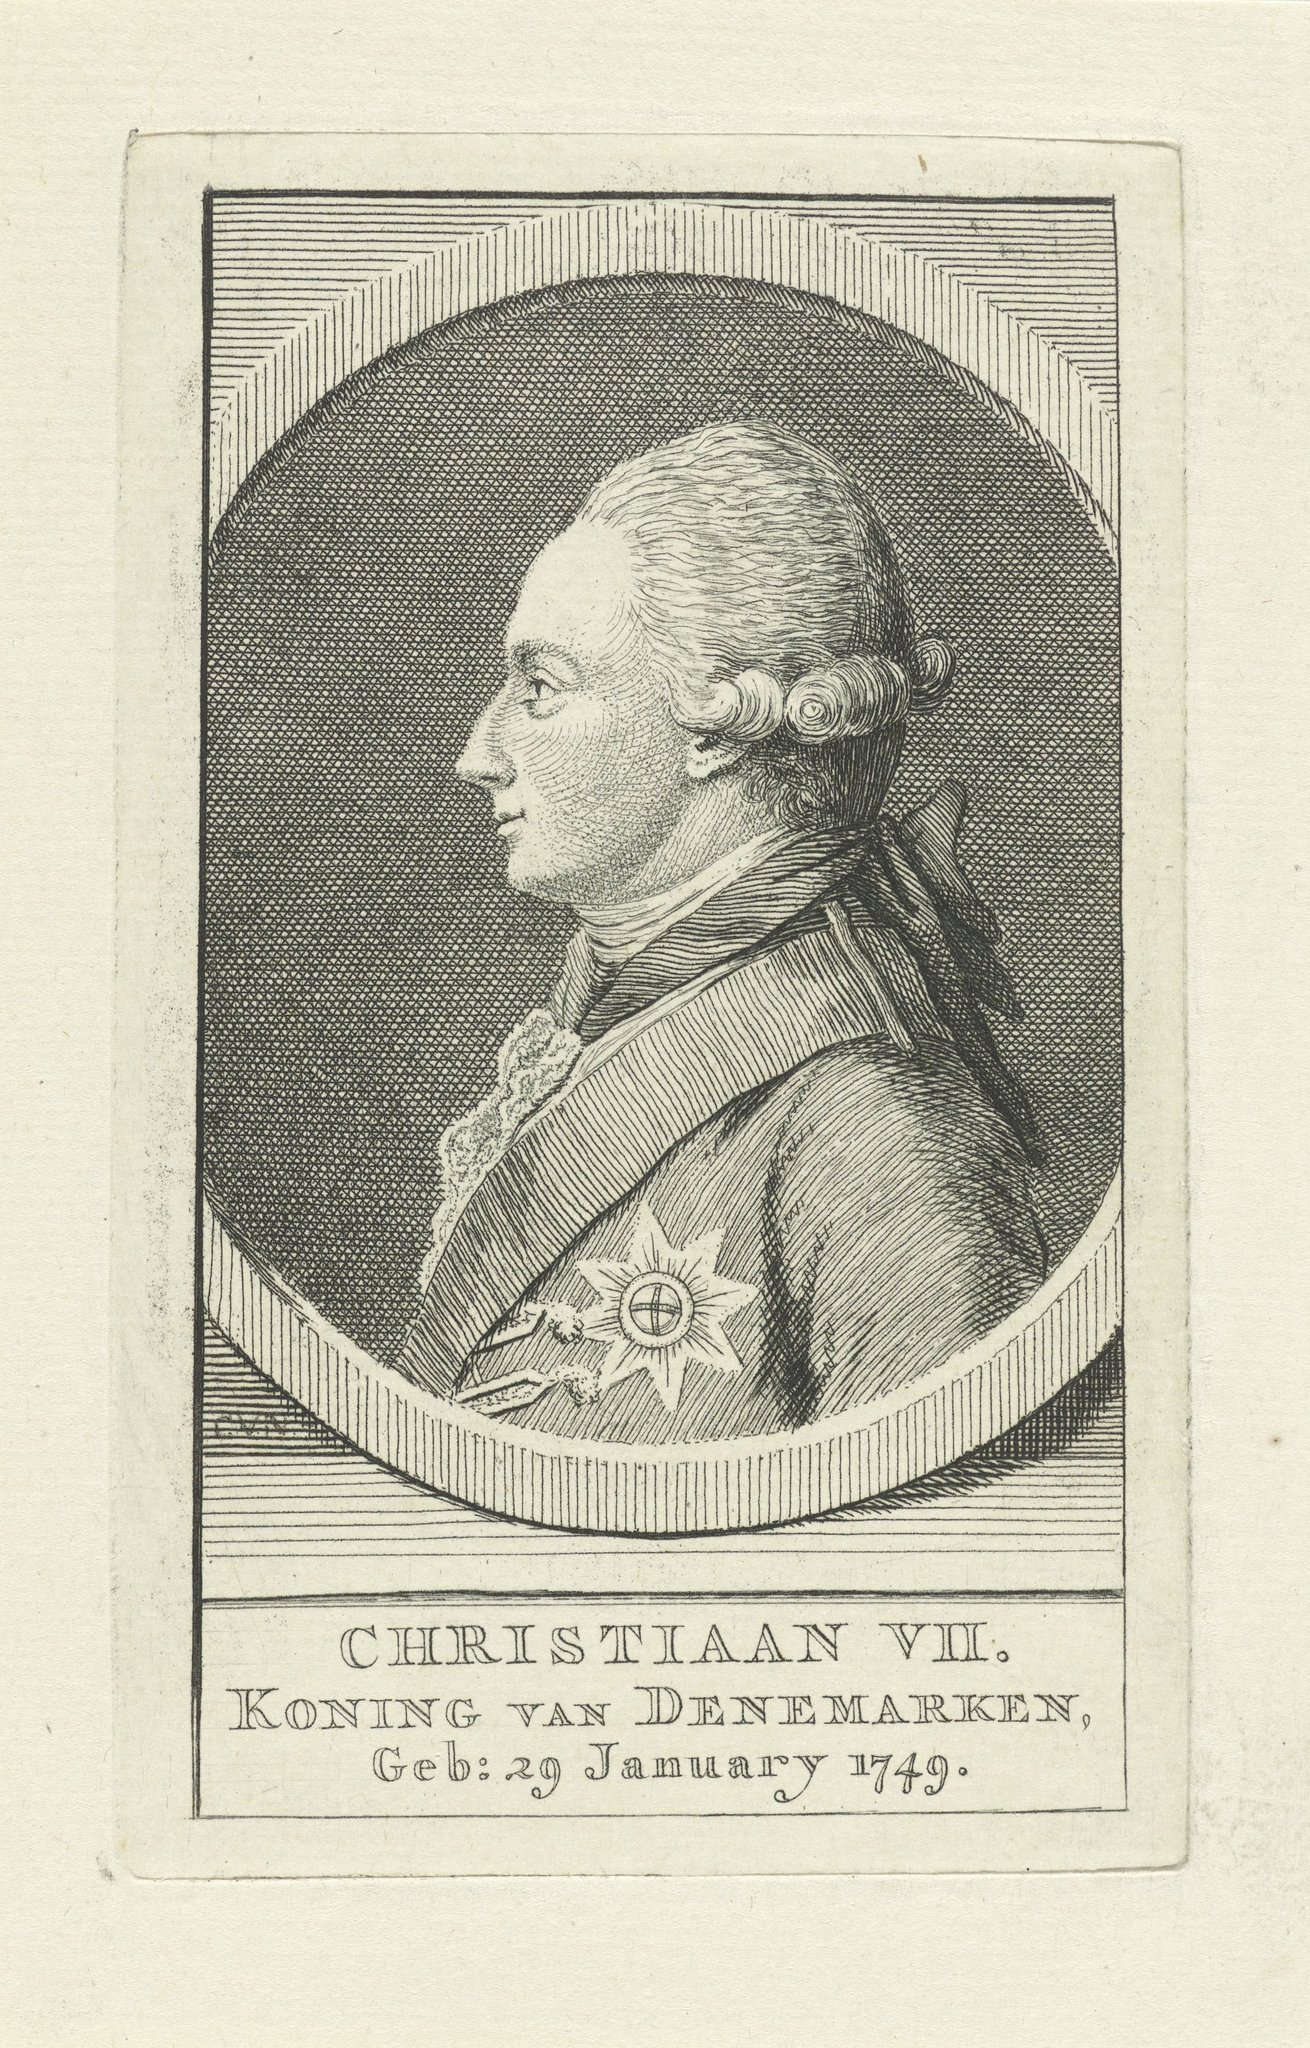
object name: print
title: Portret van koning Christiaan VII van Denemarken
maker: cornelis van noorde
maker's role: draughtsman, print maker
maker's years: 1731-1795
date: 1766-1795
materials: paper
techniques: engraving, etching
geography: haarlem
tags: copenhagen (city), christiaan vii (koning van denemarken)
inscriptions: collector's mark: Lugt 240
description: Portret van Christiaan VII, koning van Denemarken.